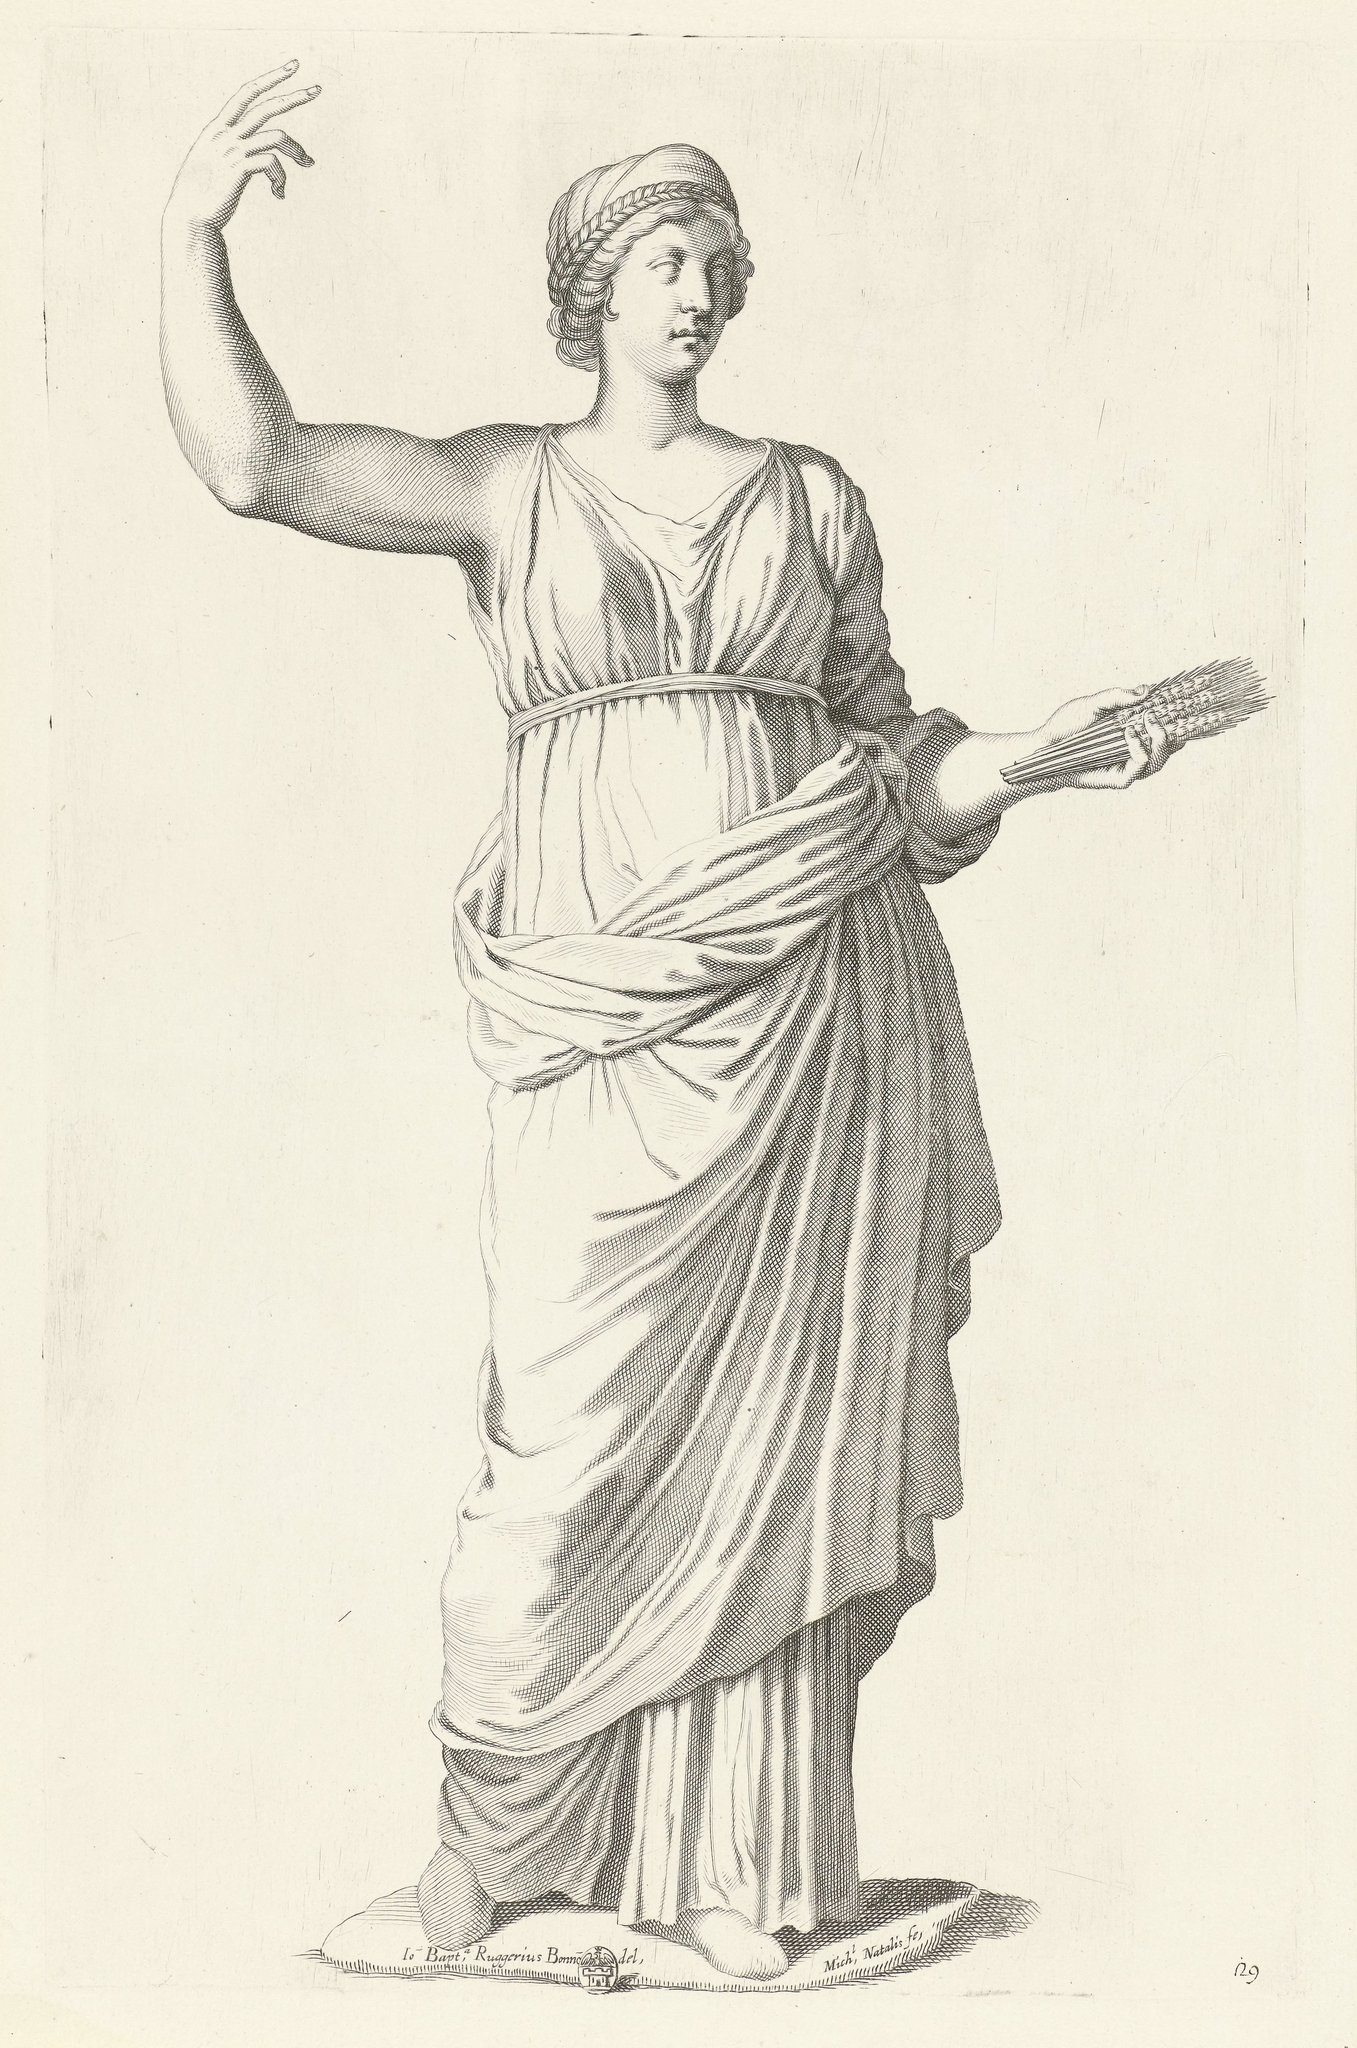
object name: print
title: Galleria Giustiniana del Marchese Vincenzo Giustiniani I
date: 1640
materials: paper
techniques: engraving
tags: rome, vincenzo giustiniani (1564-1637), (story of) ceres (demeter), sheaf of corn as attribute of ceres, piece of sculpture, reproduction of a piece of sculpture, monument, statue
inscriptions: collector's mark: Lugt 2228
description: Standbeeld van Ceres, gekleed in klassiek gewaad. In haar linkerhand houdt zij korenaren, haar rechterarm is omhoog geheven. Midden onder op de basis het wapenschild van Vincenzo Giustiniani. Prent uit een serie naar de sculpturen in de verzameling in de Galleria Giustiniani te Rome.